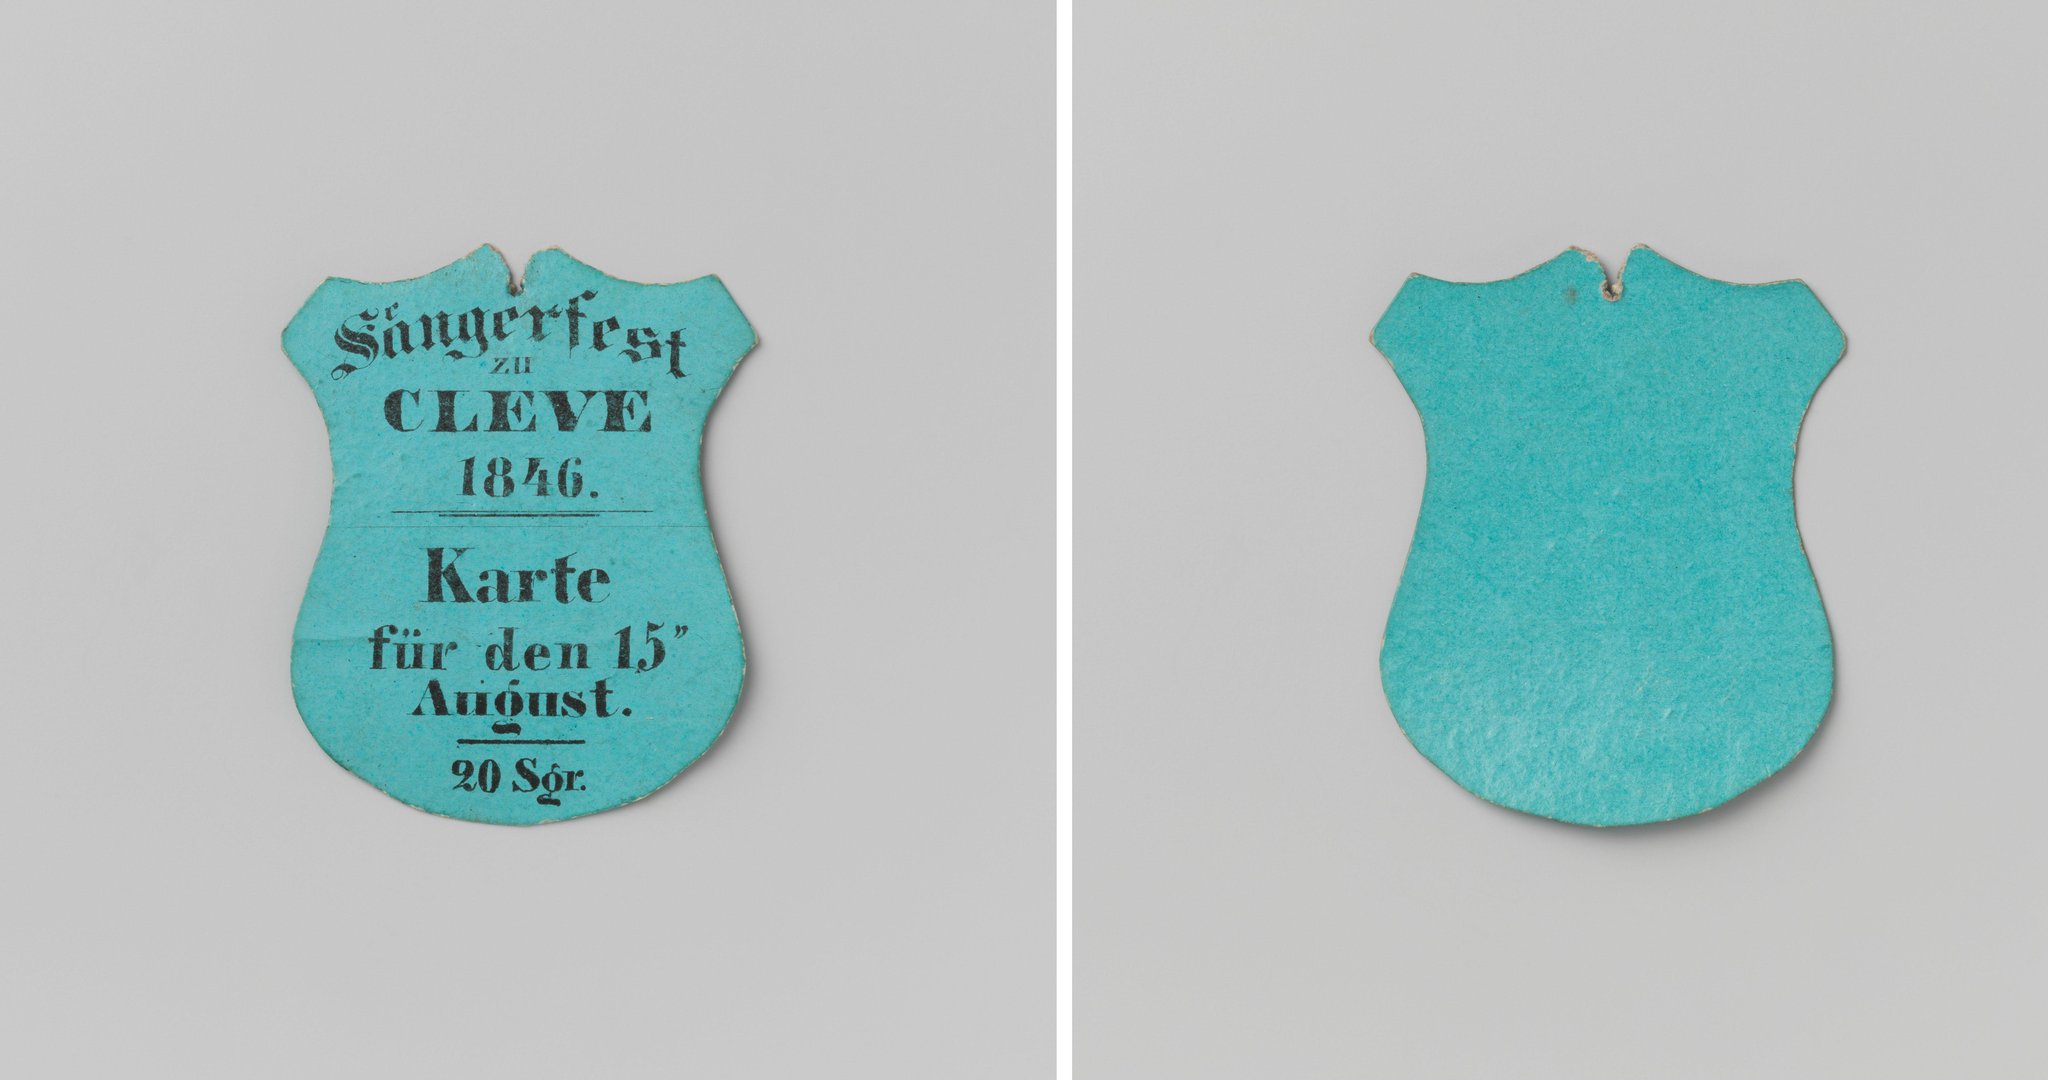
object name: admission ticket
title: Sängerfest zu Cleve, 1846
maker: Anonymous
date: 1846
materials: paper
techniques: printing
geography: germany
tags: cleves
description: eenzijdige kaart van blauw papier in de vorm van een wapenschild met achtregelig opschrift